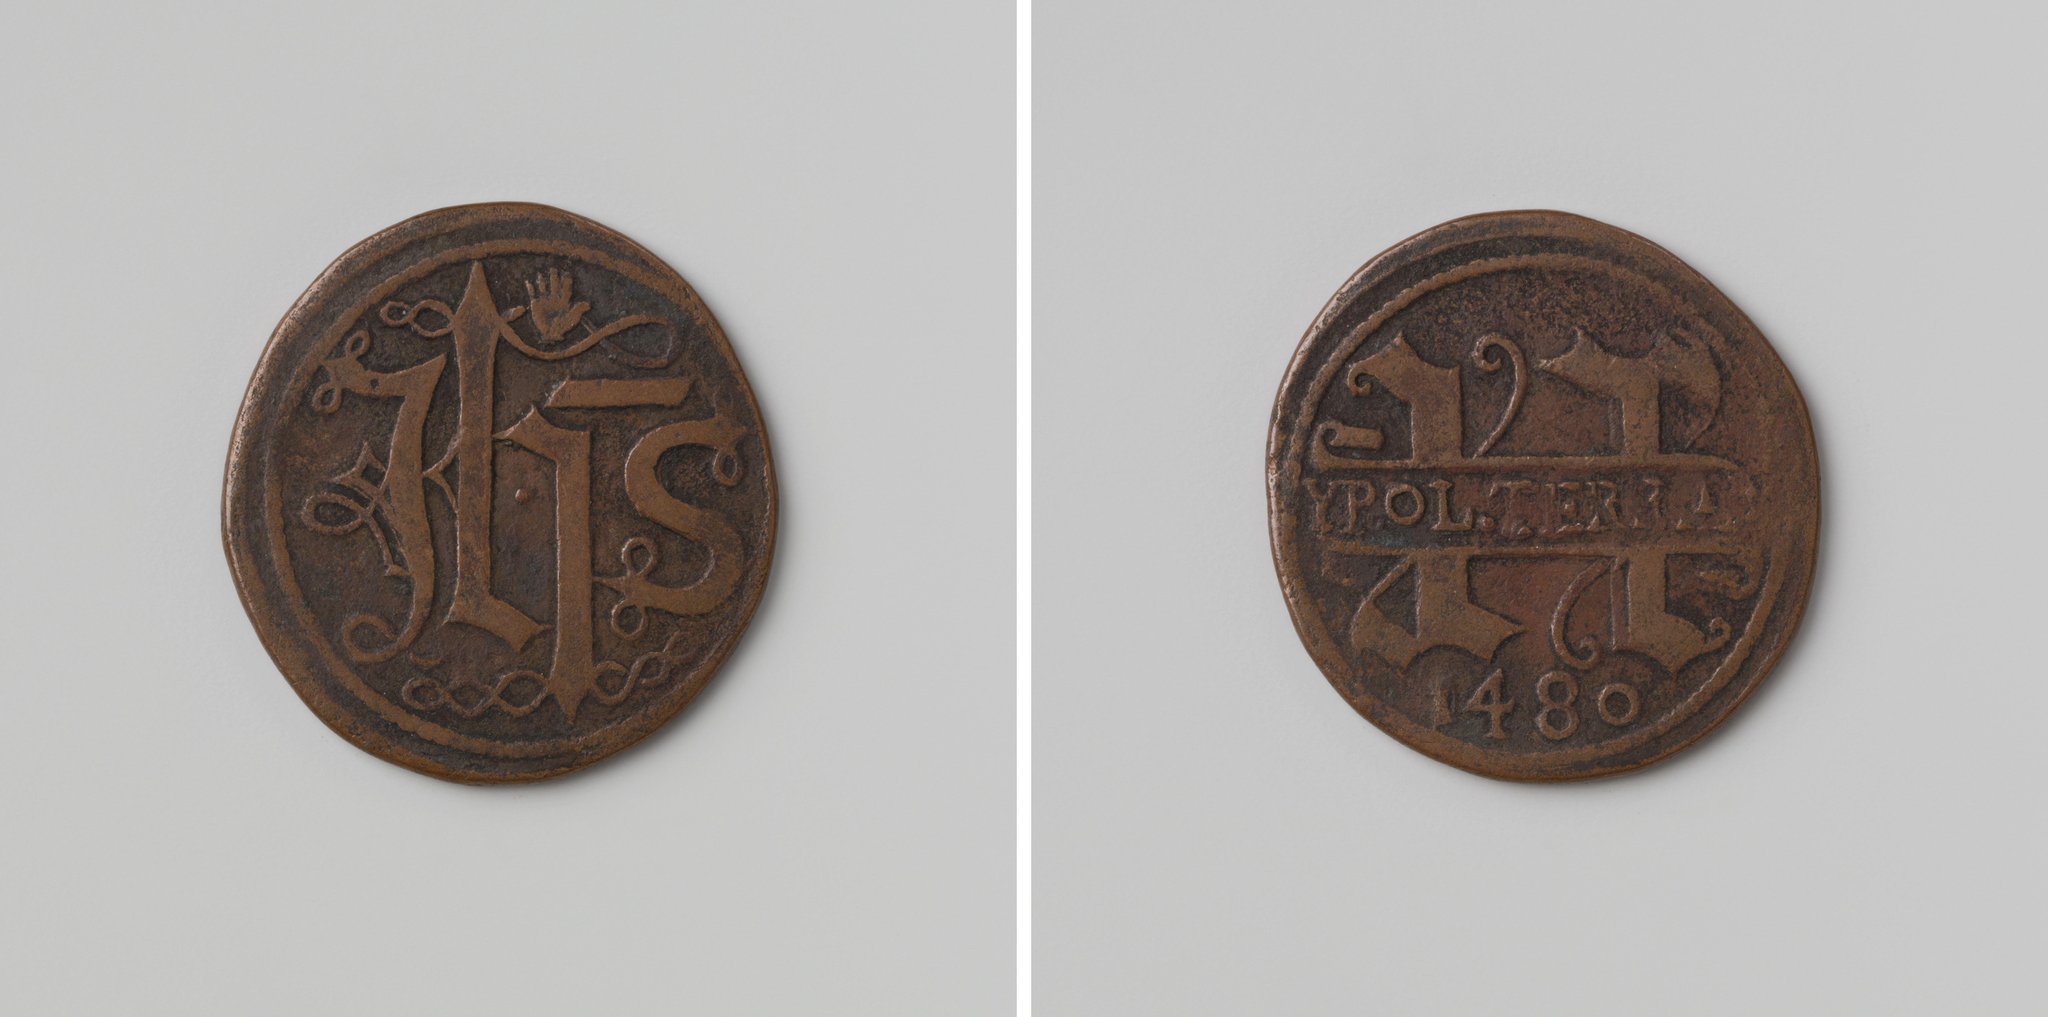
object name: jeton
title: Hippolyte Ferrax, muntmeester aan de munt van Brabant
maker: Anonymous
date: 1480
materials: copper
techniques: striking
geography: antwerp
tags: antwerp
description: Koperen penning. Voorzijde: monogram van letters IHS onder geopende hand. Keerzijde: letter H [?]; daarover een band met opschrift boven jaartal